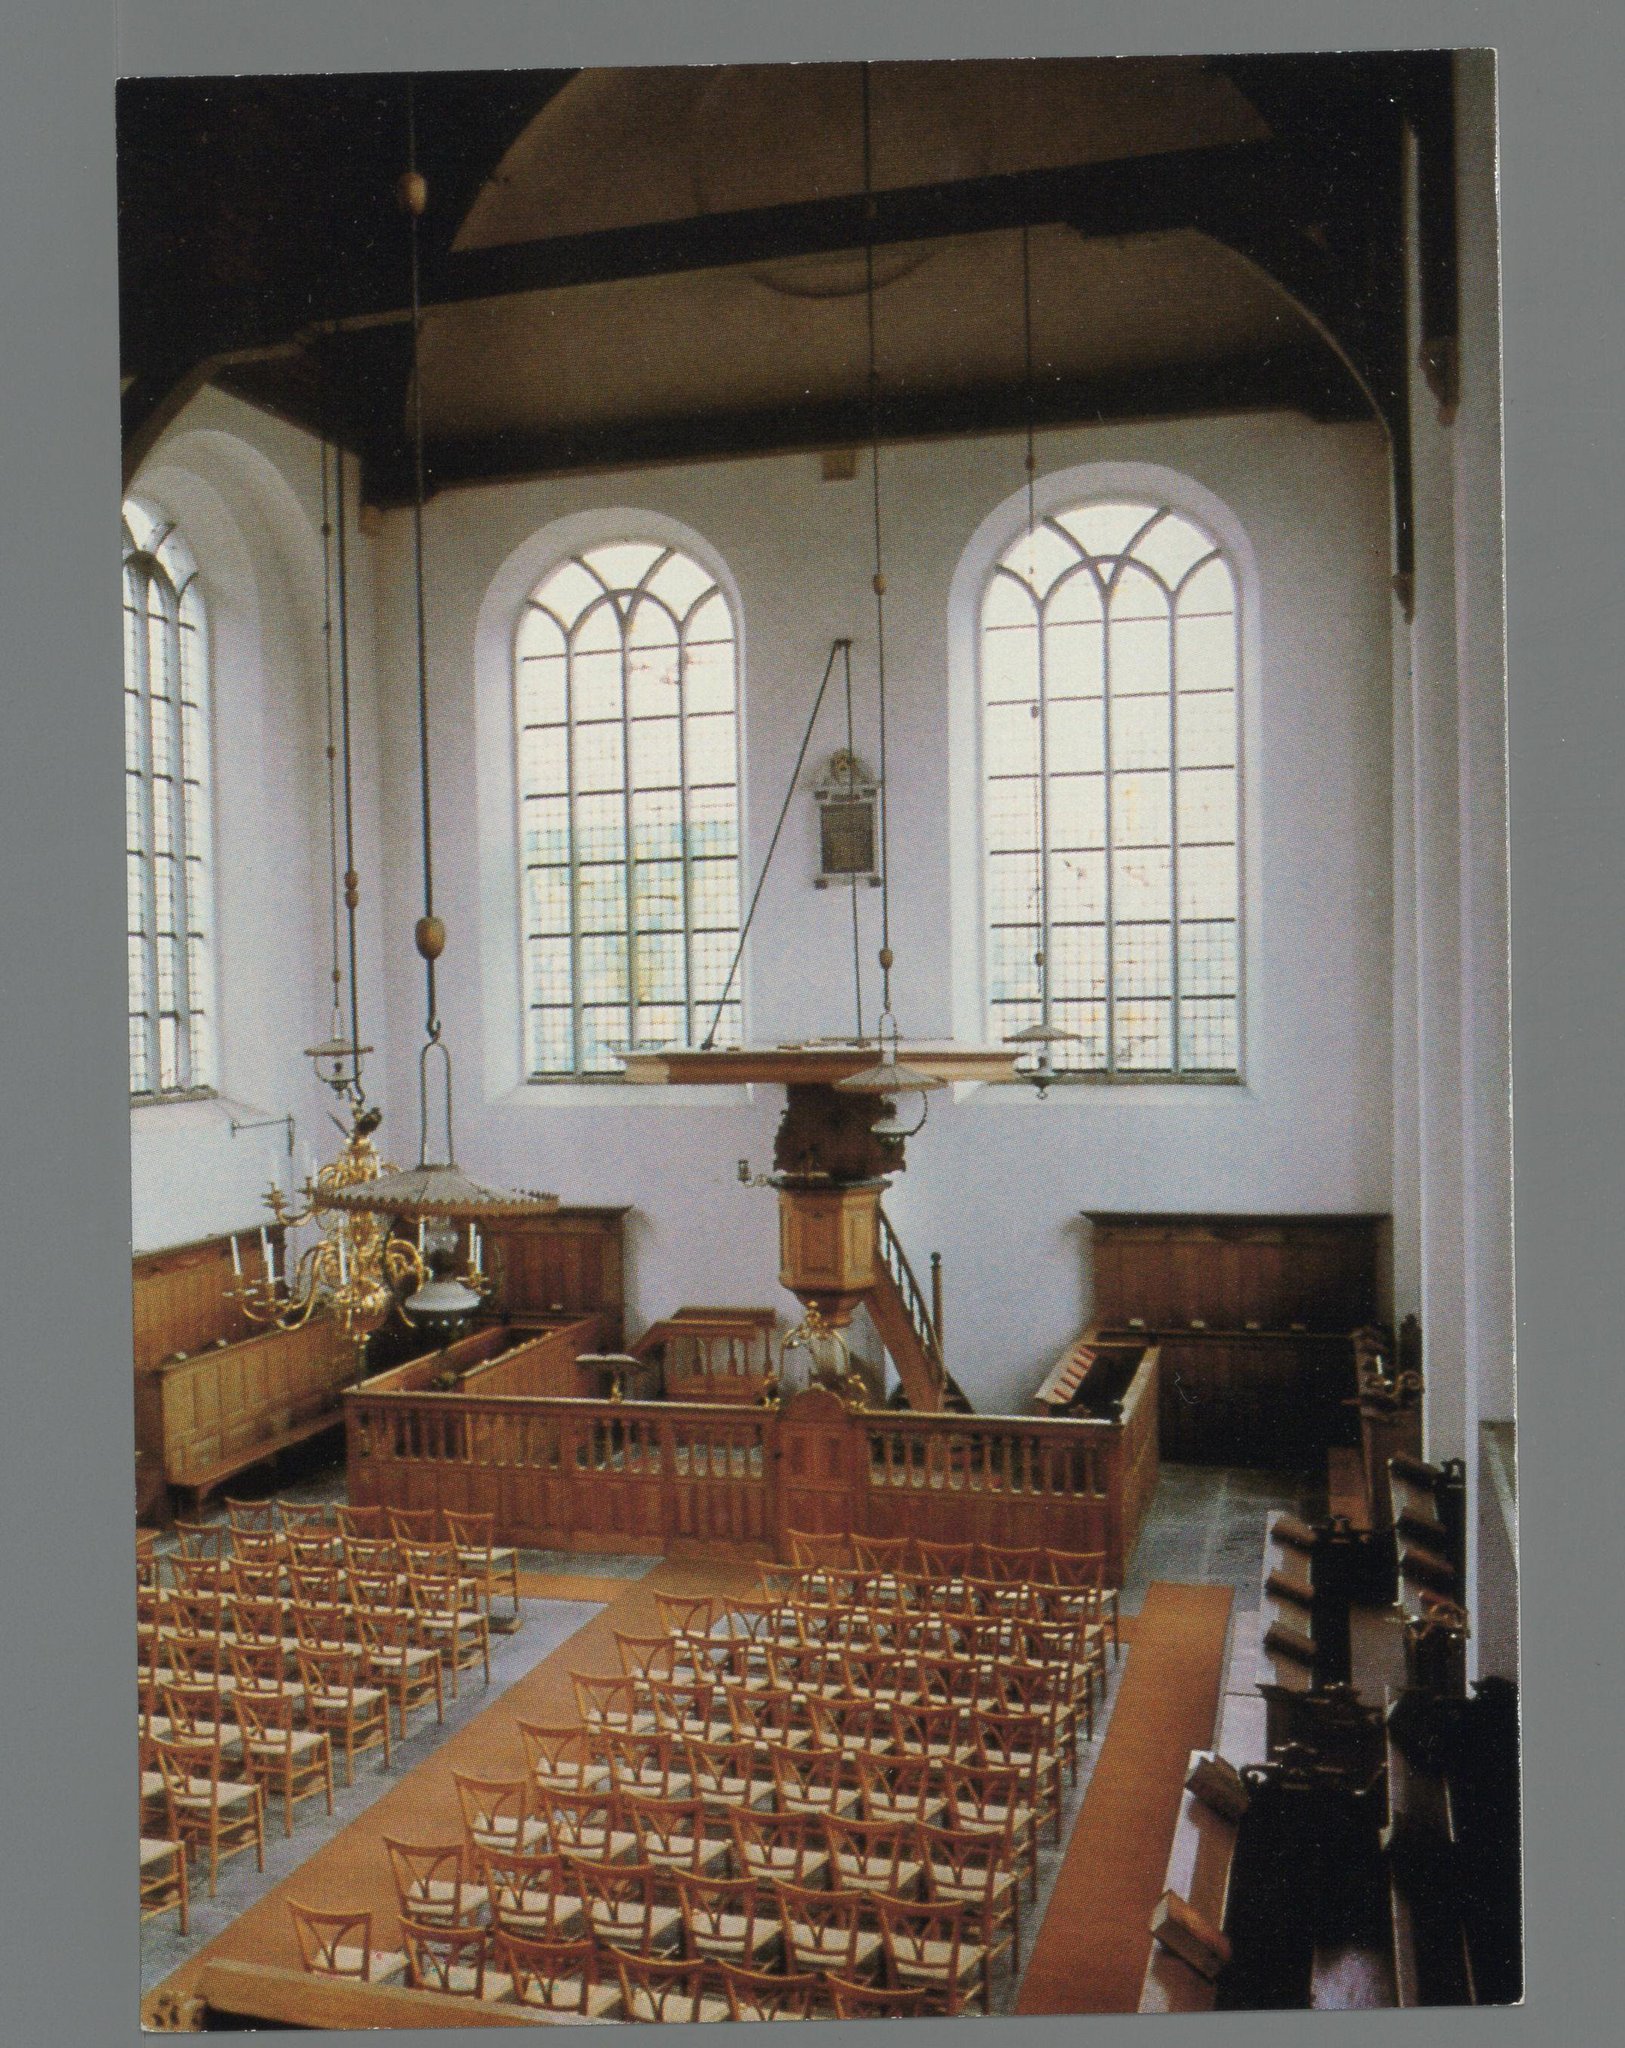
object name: photomechanical print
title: Middenbeemster Ned. Herv. Kerk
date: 1969-1989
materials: cardboard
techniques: offset printed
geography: arnhem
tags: interior of church, pulpit, ambo, chancel